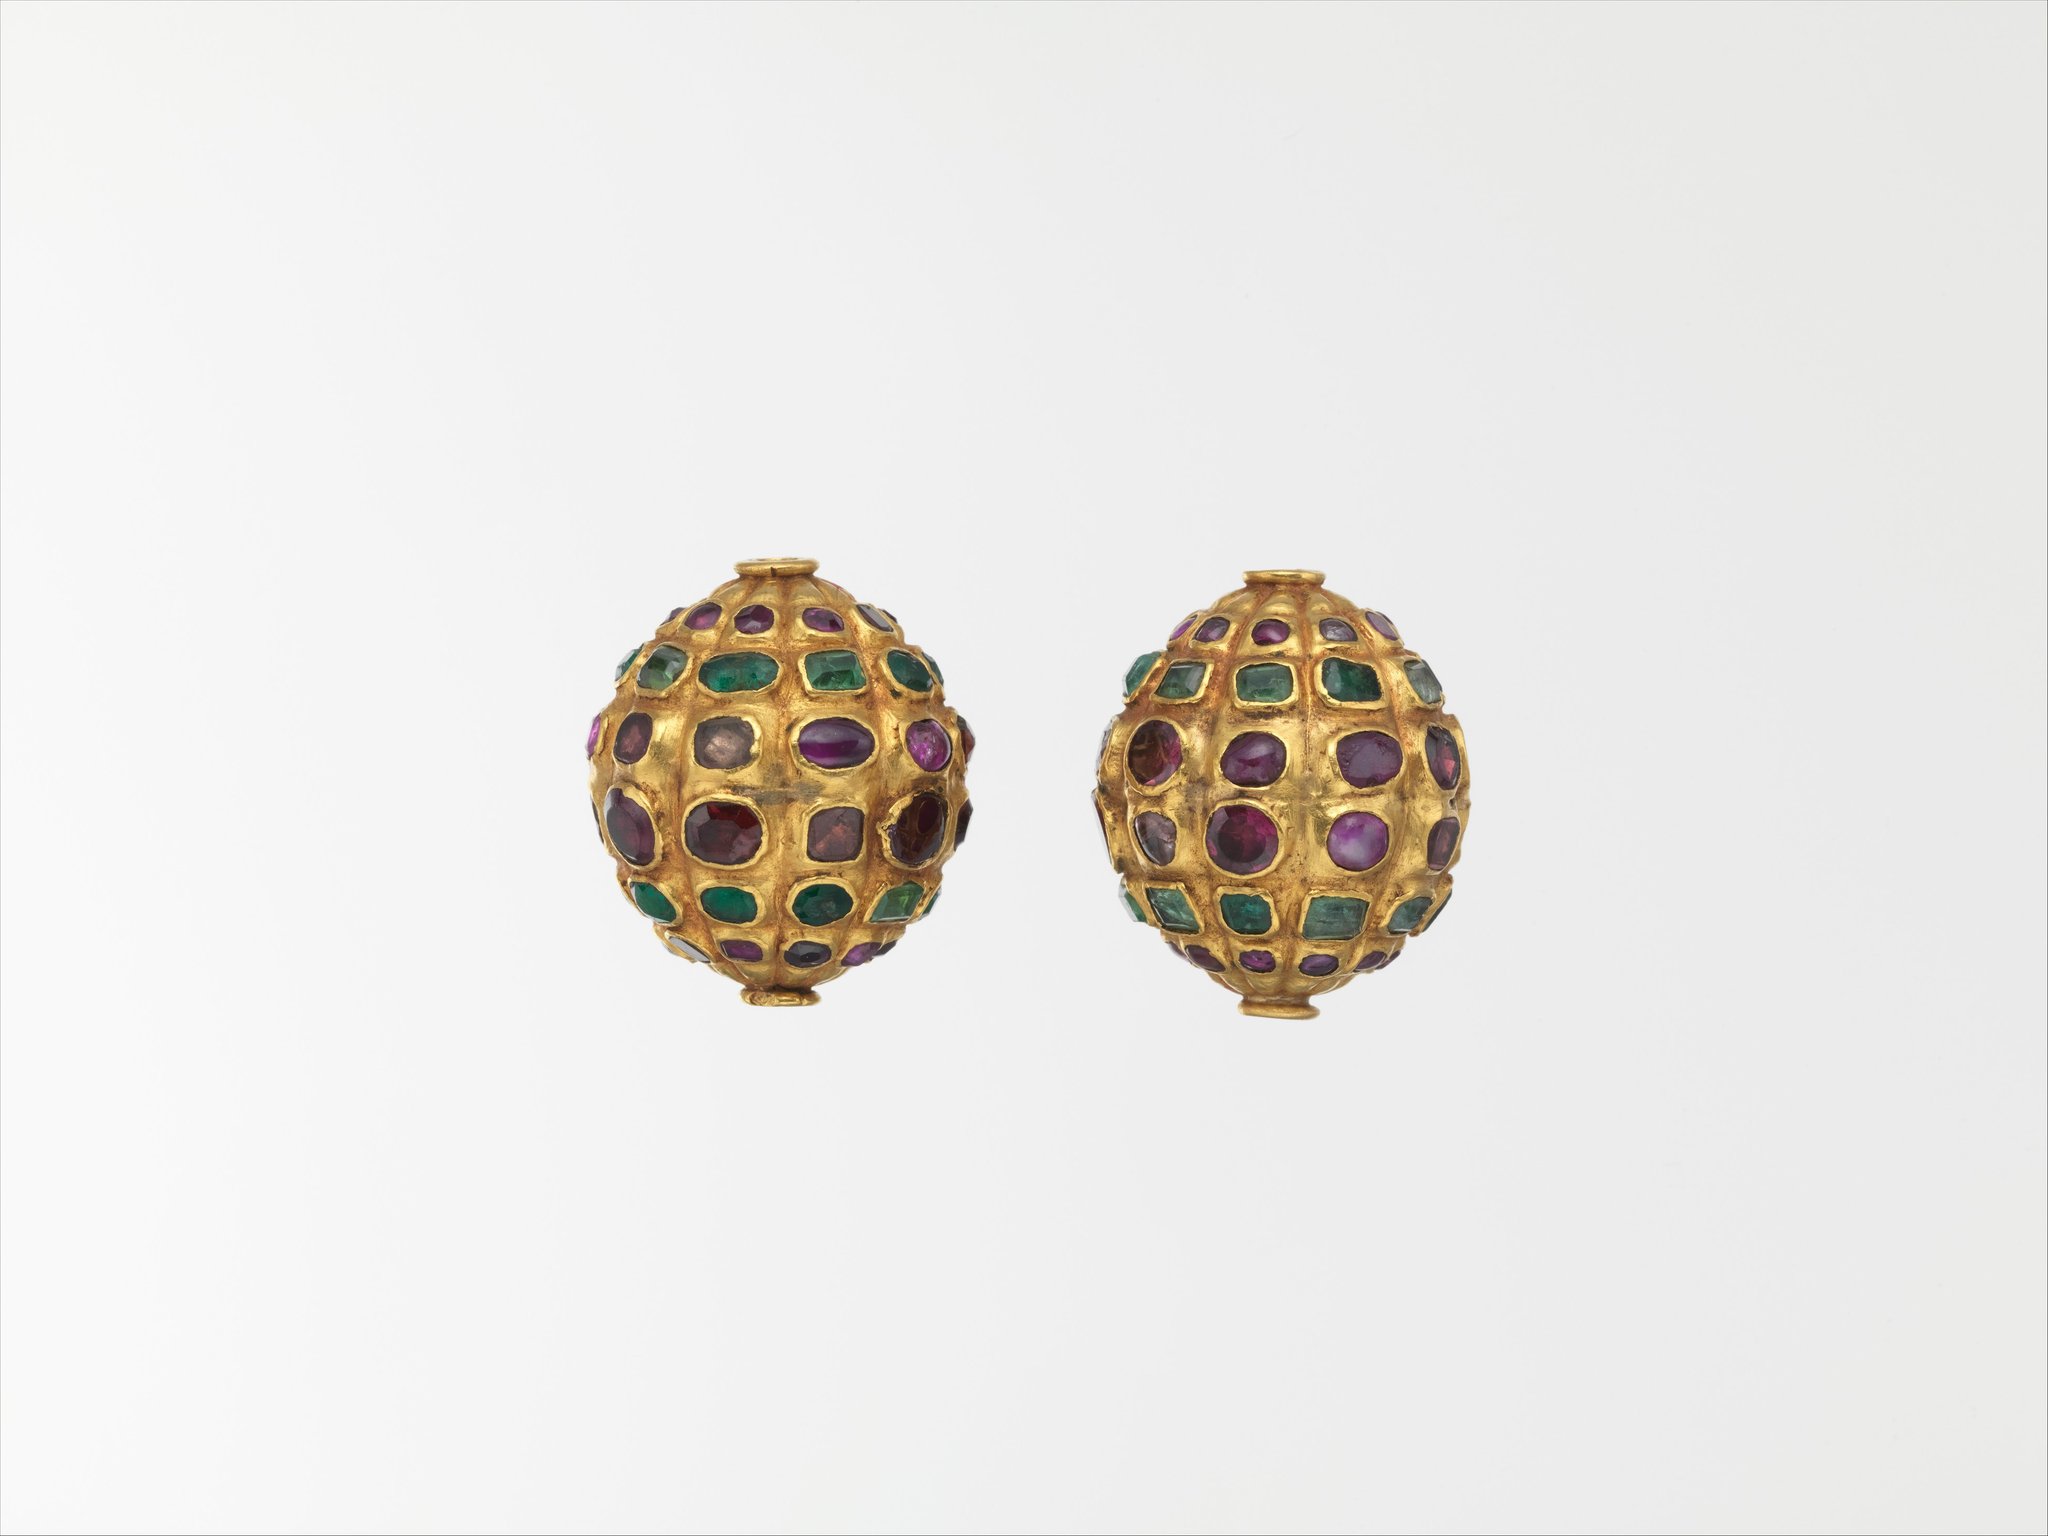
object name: bead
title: Bead, One of a Pair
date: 1701-1800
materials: gemstone, gold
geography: morocco